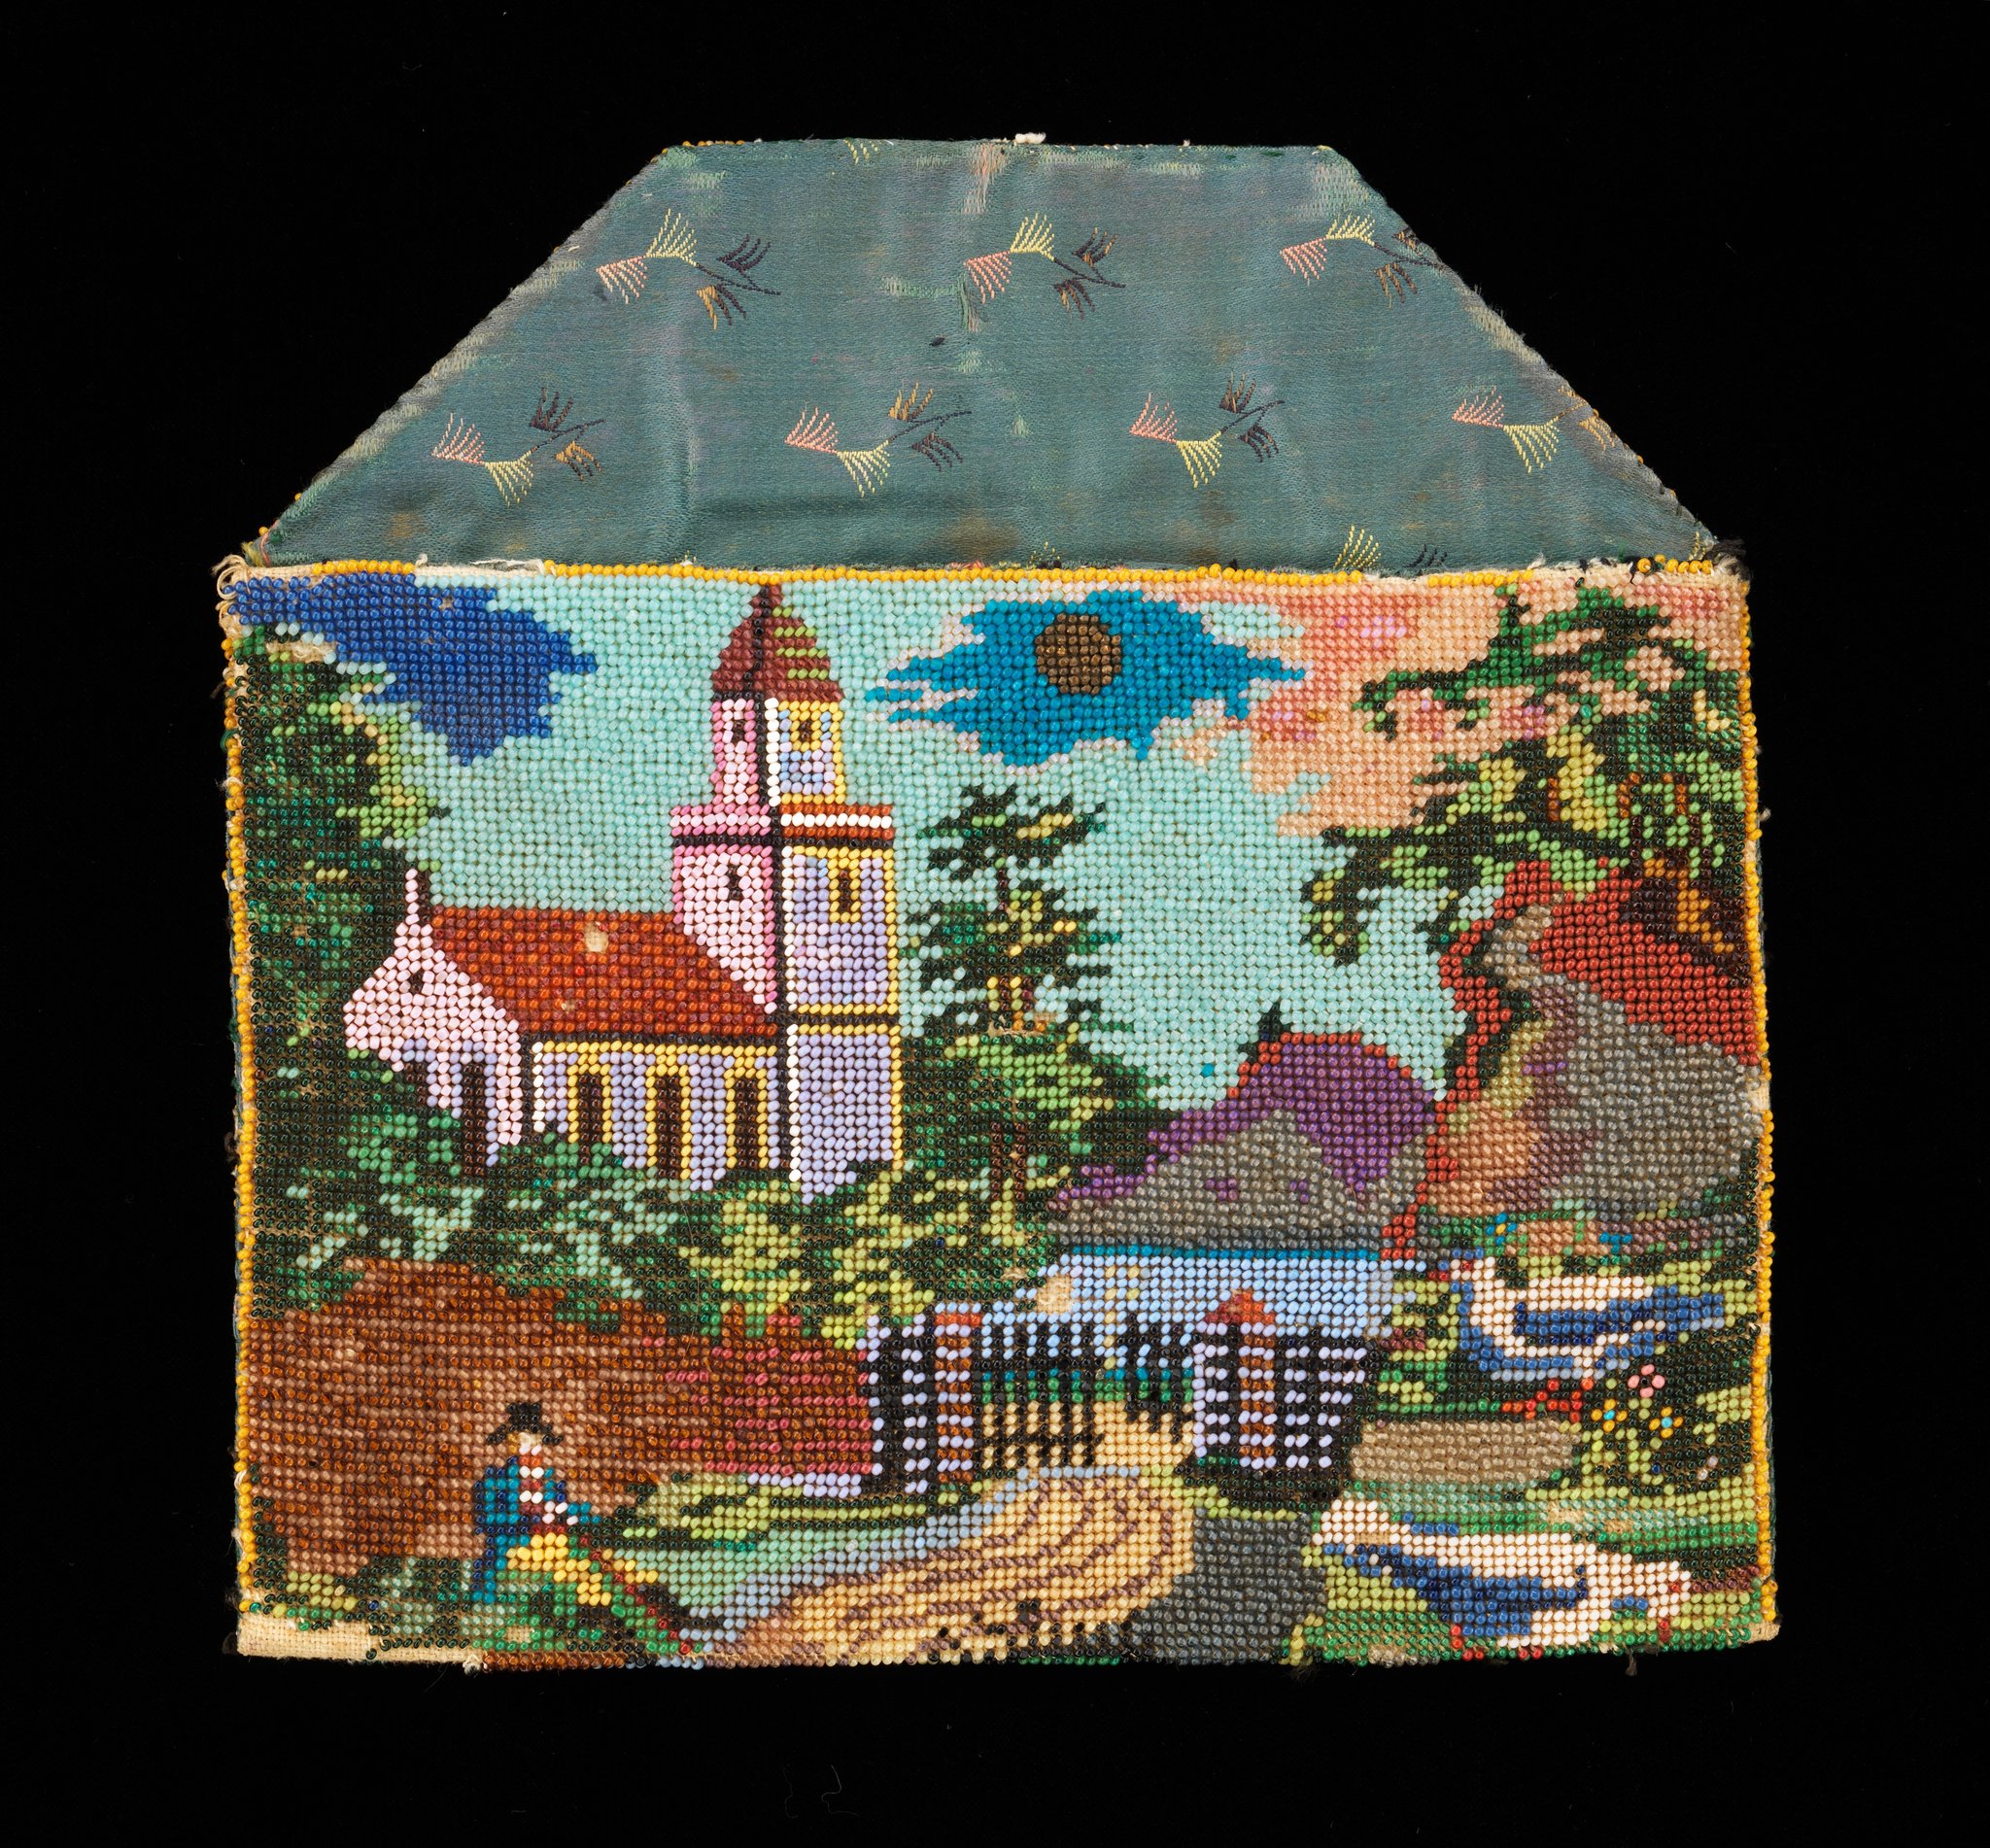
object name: clutch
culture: mexican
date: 1830-1850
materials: glass, linen, silk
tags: ducks,churches,men